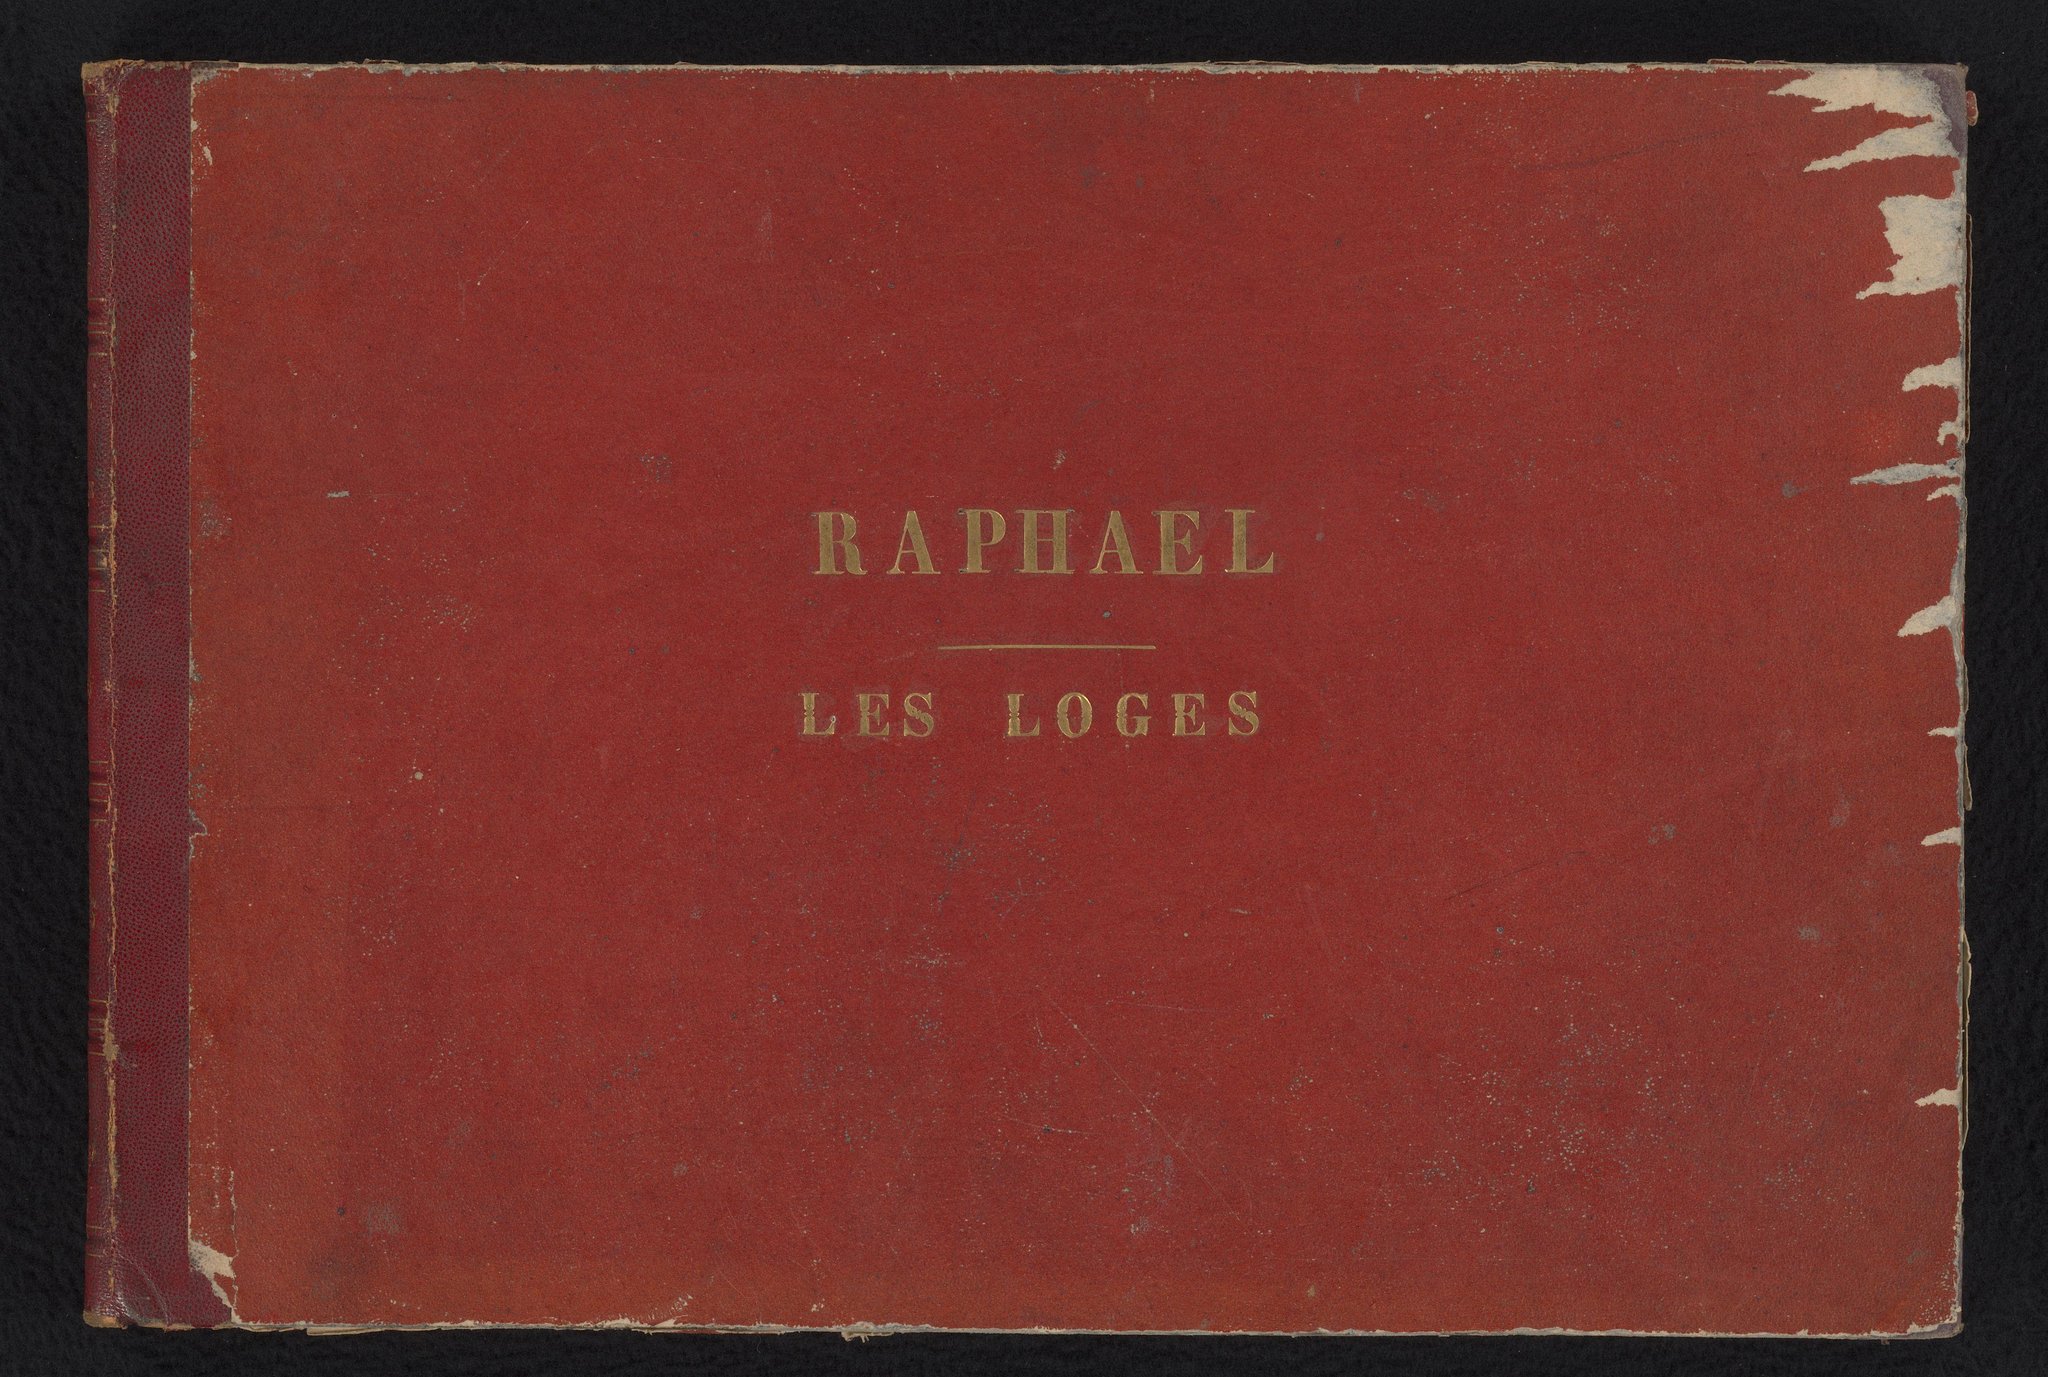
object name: prentrecueil, prentenalbum, prentalbum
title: Sacrae historiae acta a Raphaele Urbin in Vaticanis xystis ad picturae miraculum expressa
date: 1649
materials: cardboard, leather, paper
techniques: bookbinding, printing, etching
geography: france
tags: rome, rafaël, mural painter, print, e.g.: engraving, etching, lithograph, book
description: Album met een serie prenten door Nicolas Chaperon. De serie bestaat uit 54 platen, waarvan twee titelprenten. De overige 52 platen betreffen composities naar schilderingen in de Loggia van Rafaël in het Vaticaan.